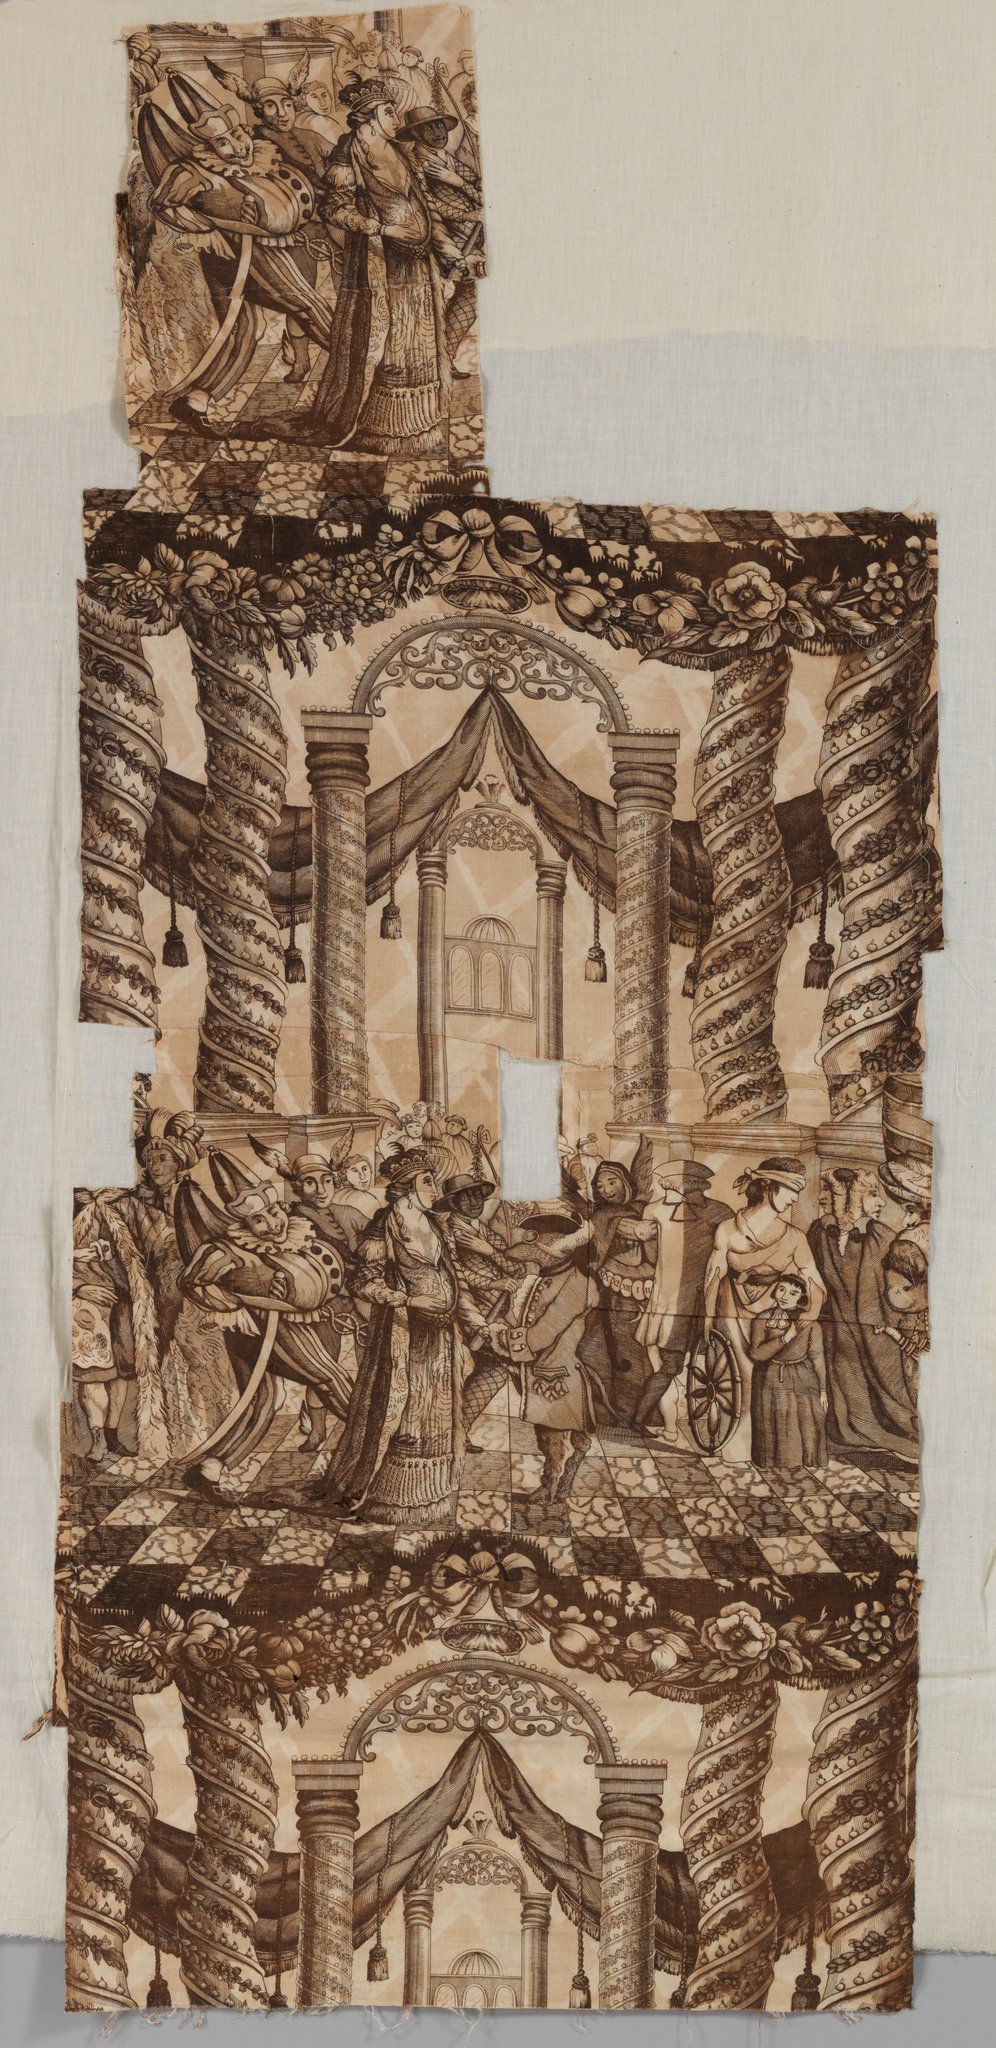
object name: panel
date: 1801-1850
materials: cotton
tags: columns,girls,men,women